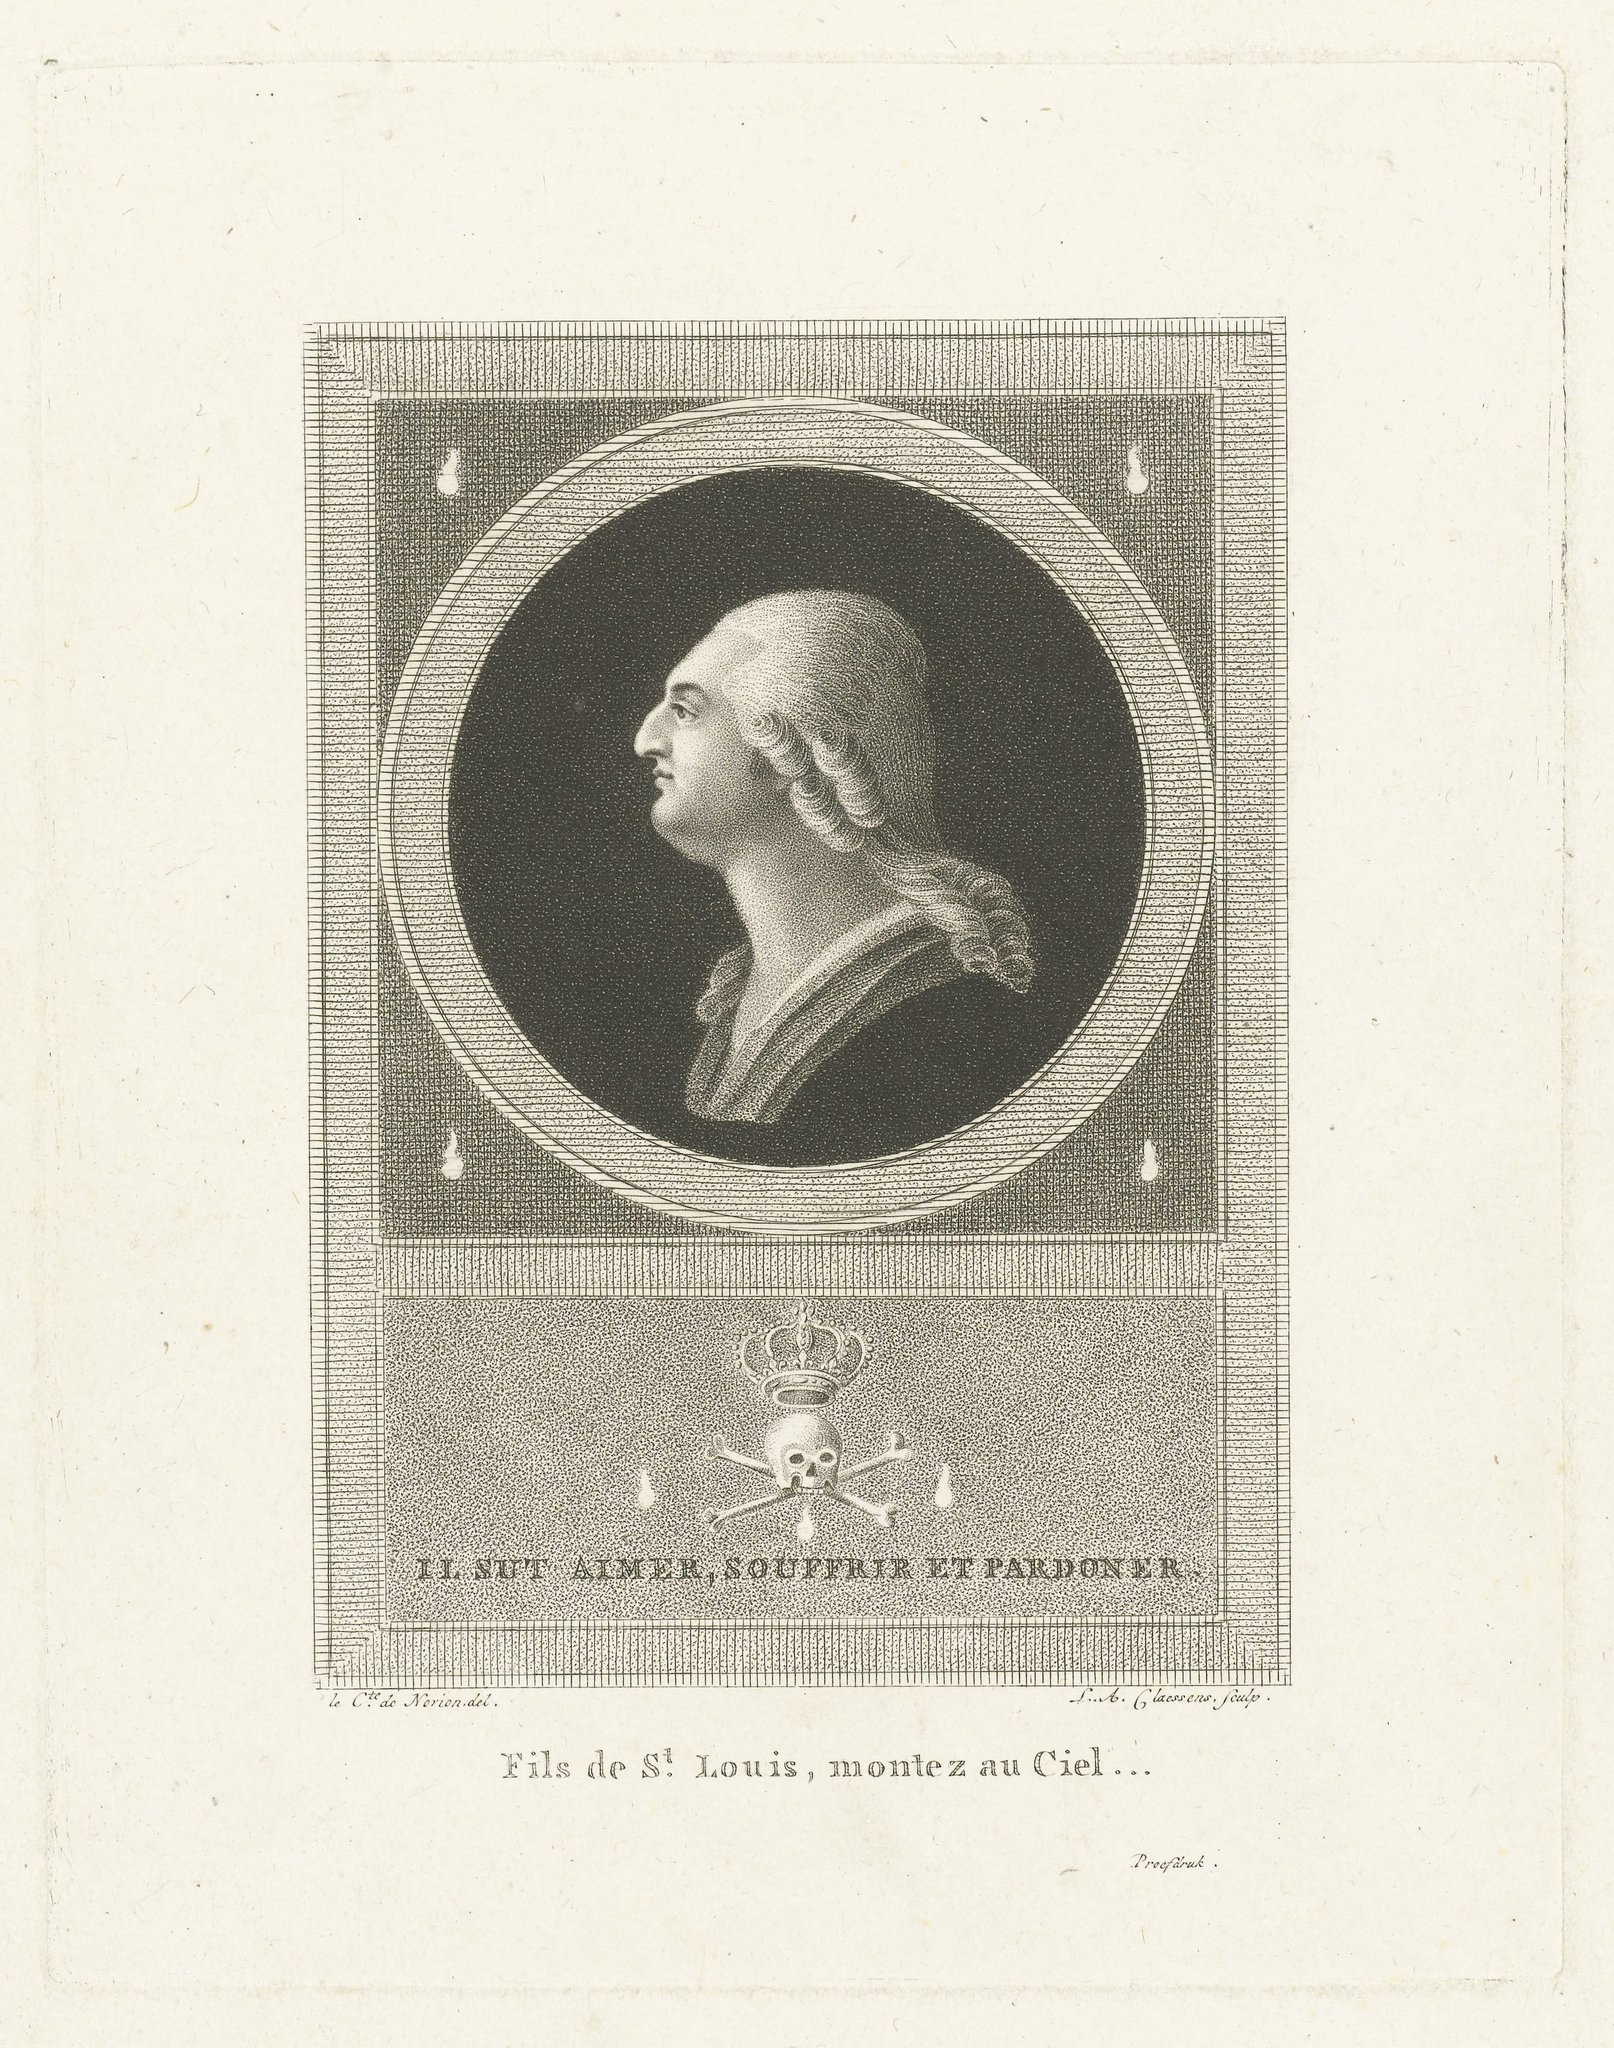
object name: print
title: Memorieprent met portret van Lodewijk XVI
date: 1793-1808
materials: paper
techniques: engraving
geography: amsterdam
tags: paris, lodewijk xvi (koning van frankrijk)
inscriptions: collector's mark: Lugt 2228